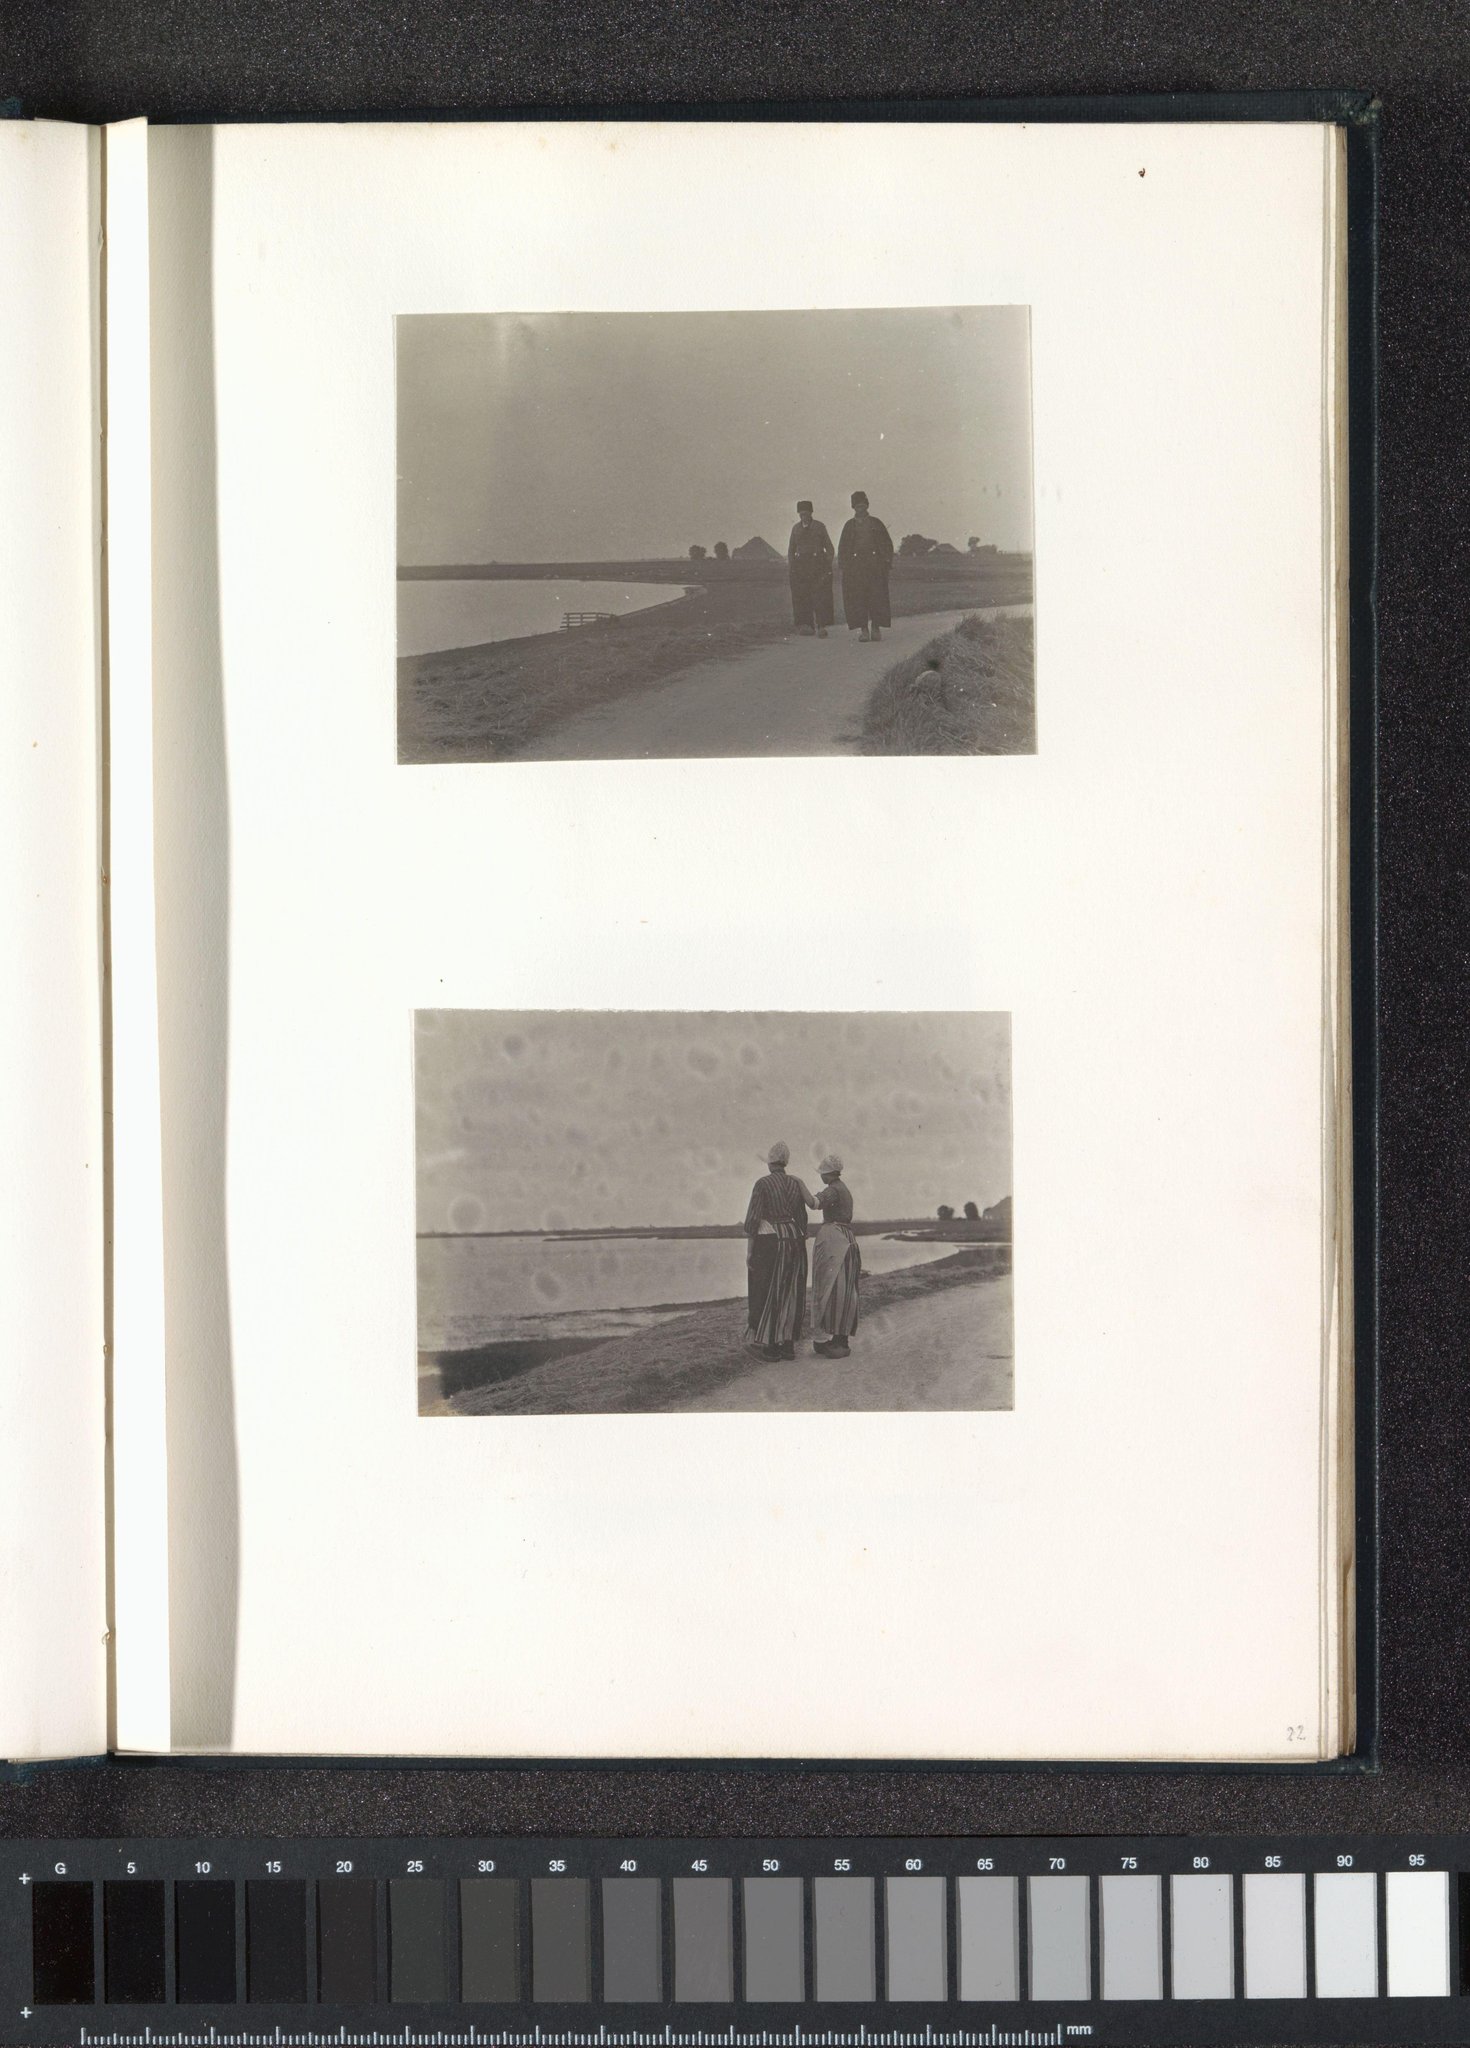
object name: photograph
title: Twee vrouwen in Volendamse klederdracht staand op een dijk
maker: george hidderley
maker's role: fotograaf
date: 1900-1910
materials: paper, photographic support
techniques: gelatin silver print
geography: volendam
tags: folk costume, regional costume (+ women's clothes), dikes, levee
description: Onderdeel van fotoalbum met opnames van Volendam, Dordrecht, Gorinchem en Woudrichem.